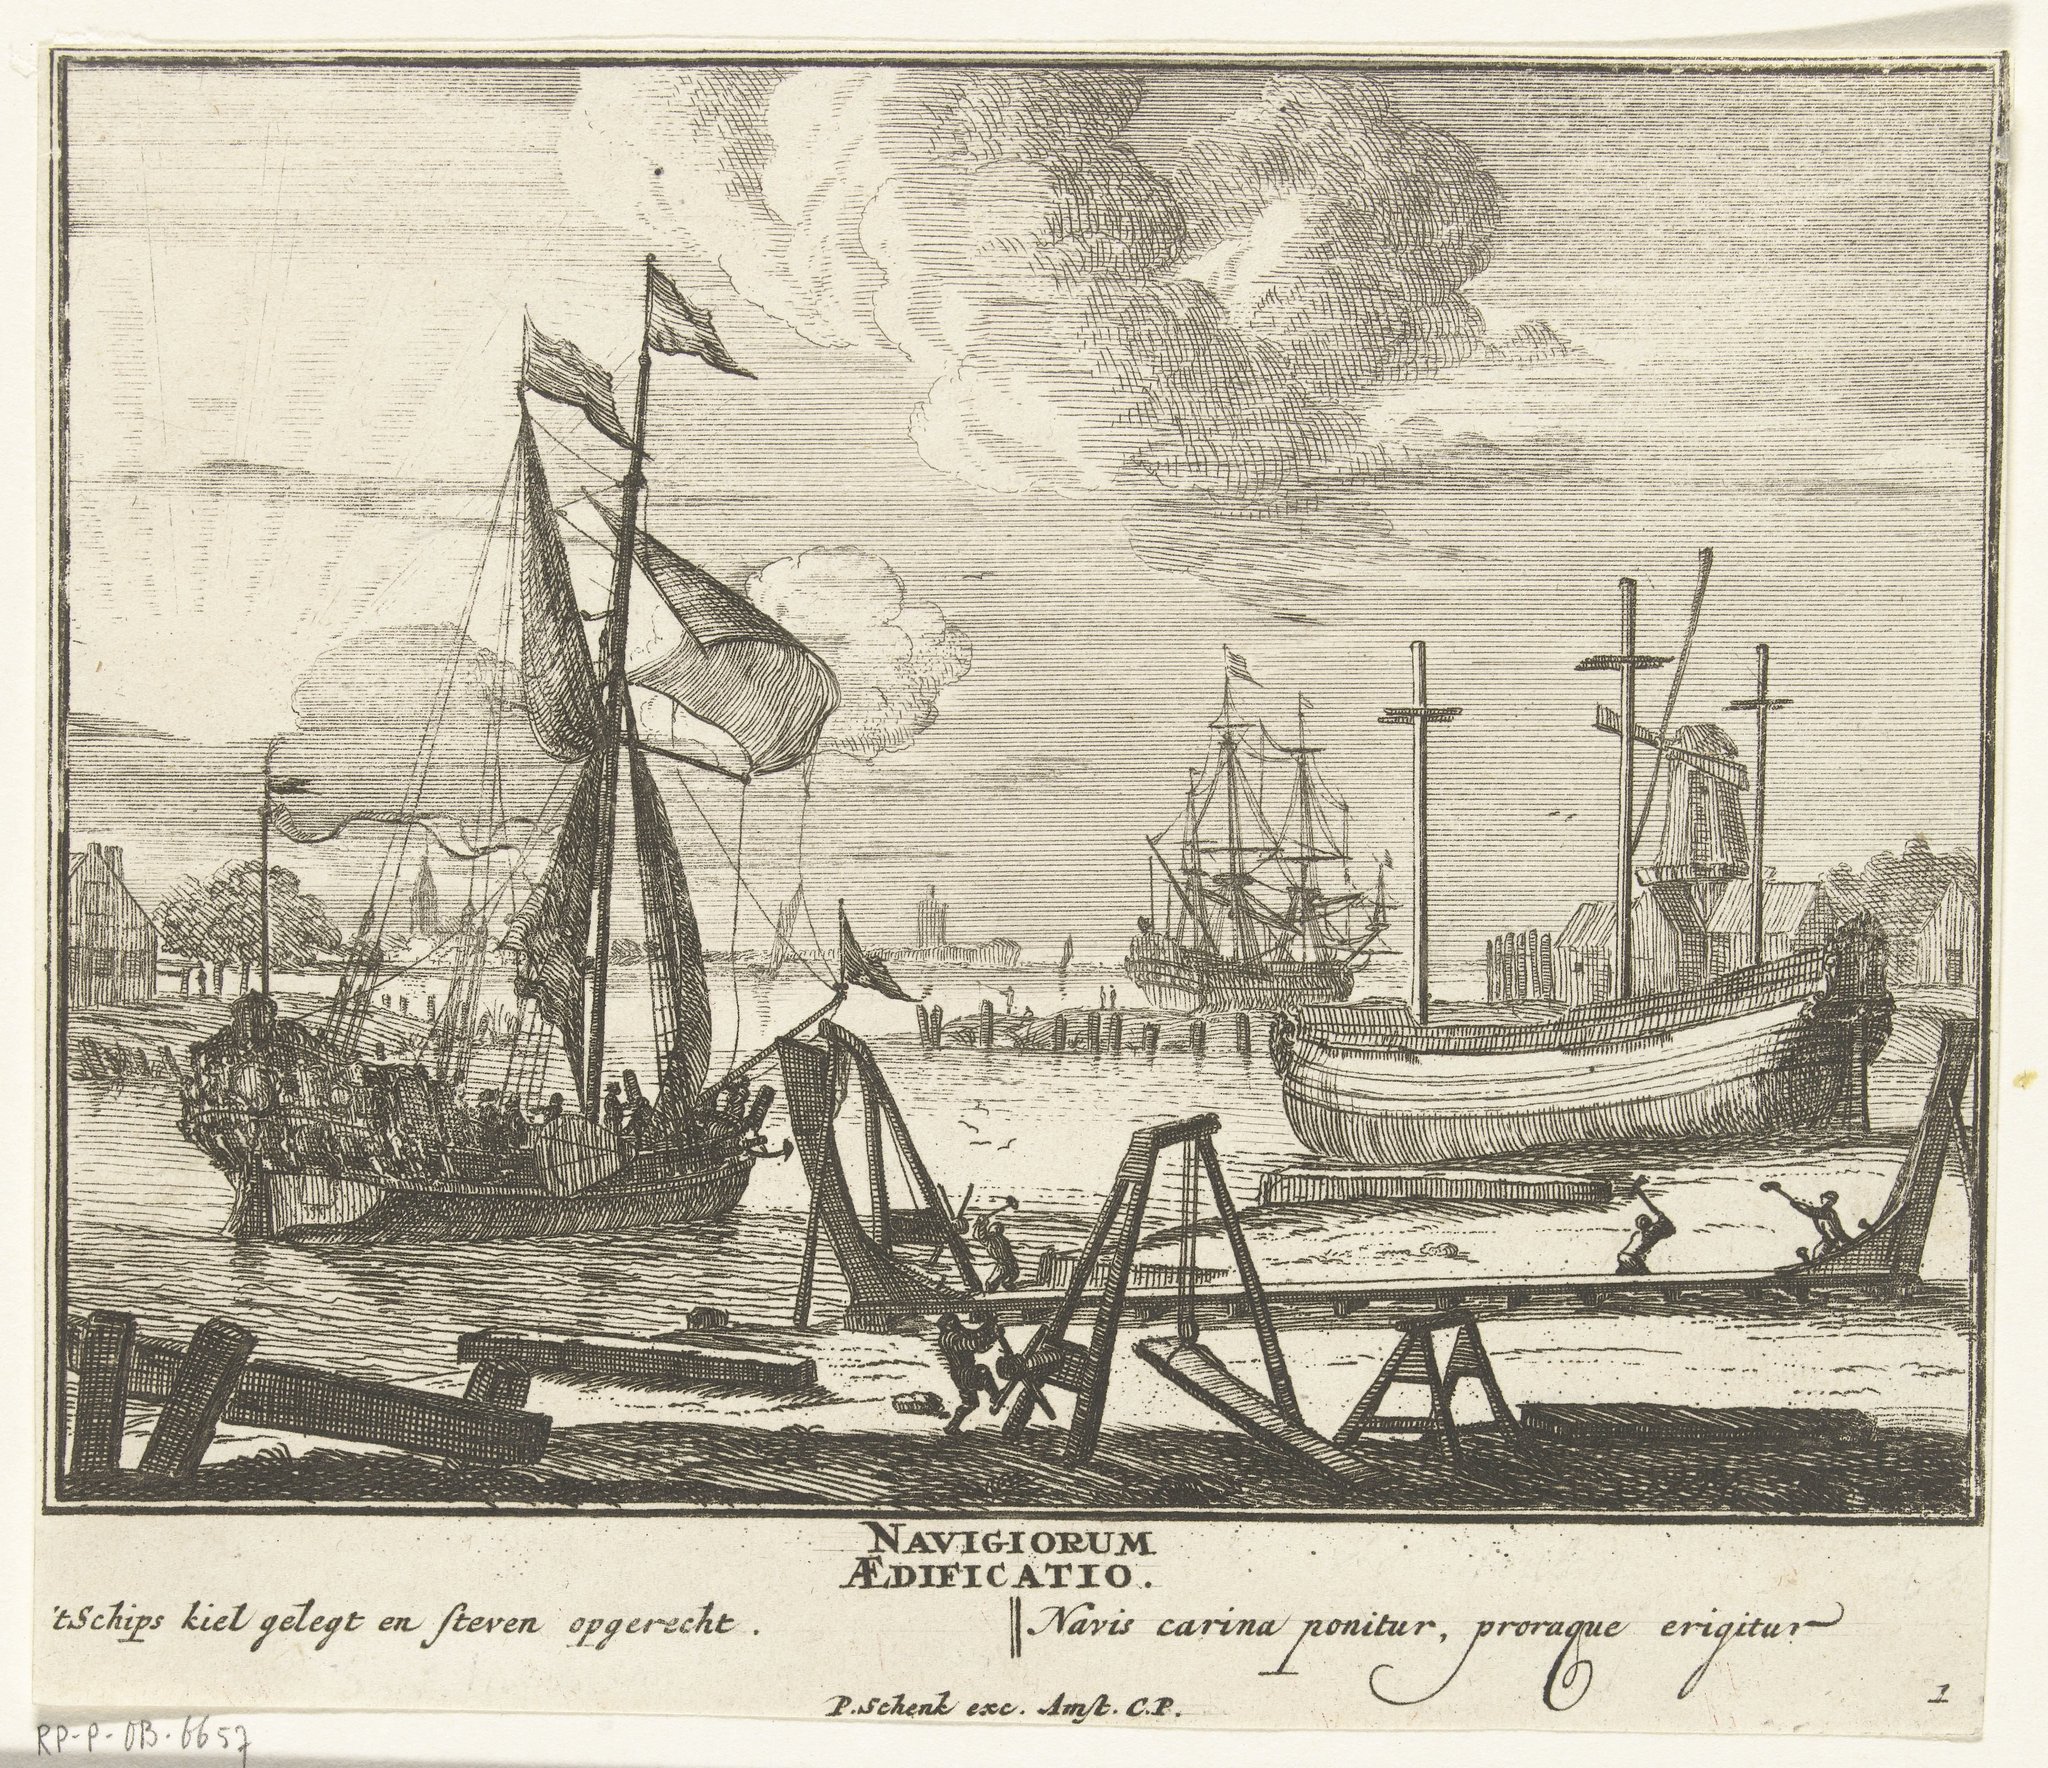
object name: print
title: Het leggen van de kiel en het oprechten van het steven, plaat nr. 1, ca. 1700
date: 1690-1710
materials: paper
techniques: etching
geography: amsterdam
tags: building a ship, ship under construction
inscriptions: title: ‘Navigiorum Aedificatio’, number: ‘1’, signature: ‘SVM’, caption: ‘'t Schips kiel gelegt en steven opgerecht’, caption: ‘Navis carina...erigitur’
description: Haven met zeilschepen en op de voorgrond een schip waarvan de kiel en steven zijn gebouwd. No. 1 uit serie van 16 prenten waarop de bouw en lotgevallen van een schip zijn afgebeeld. Met onderschriften in het Nederlands en Latijn.